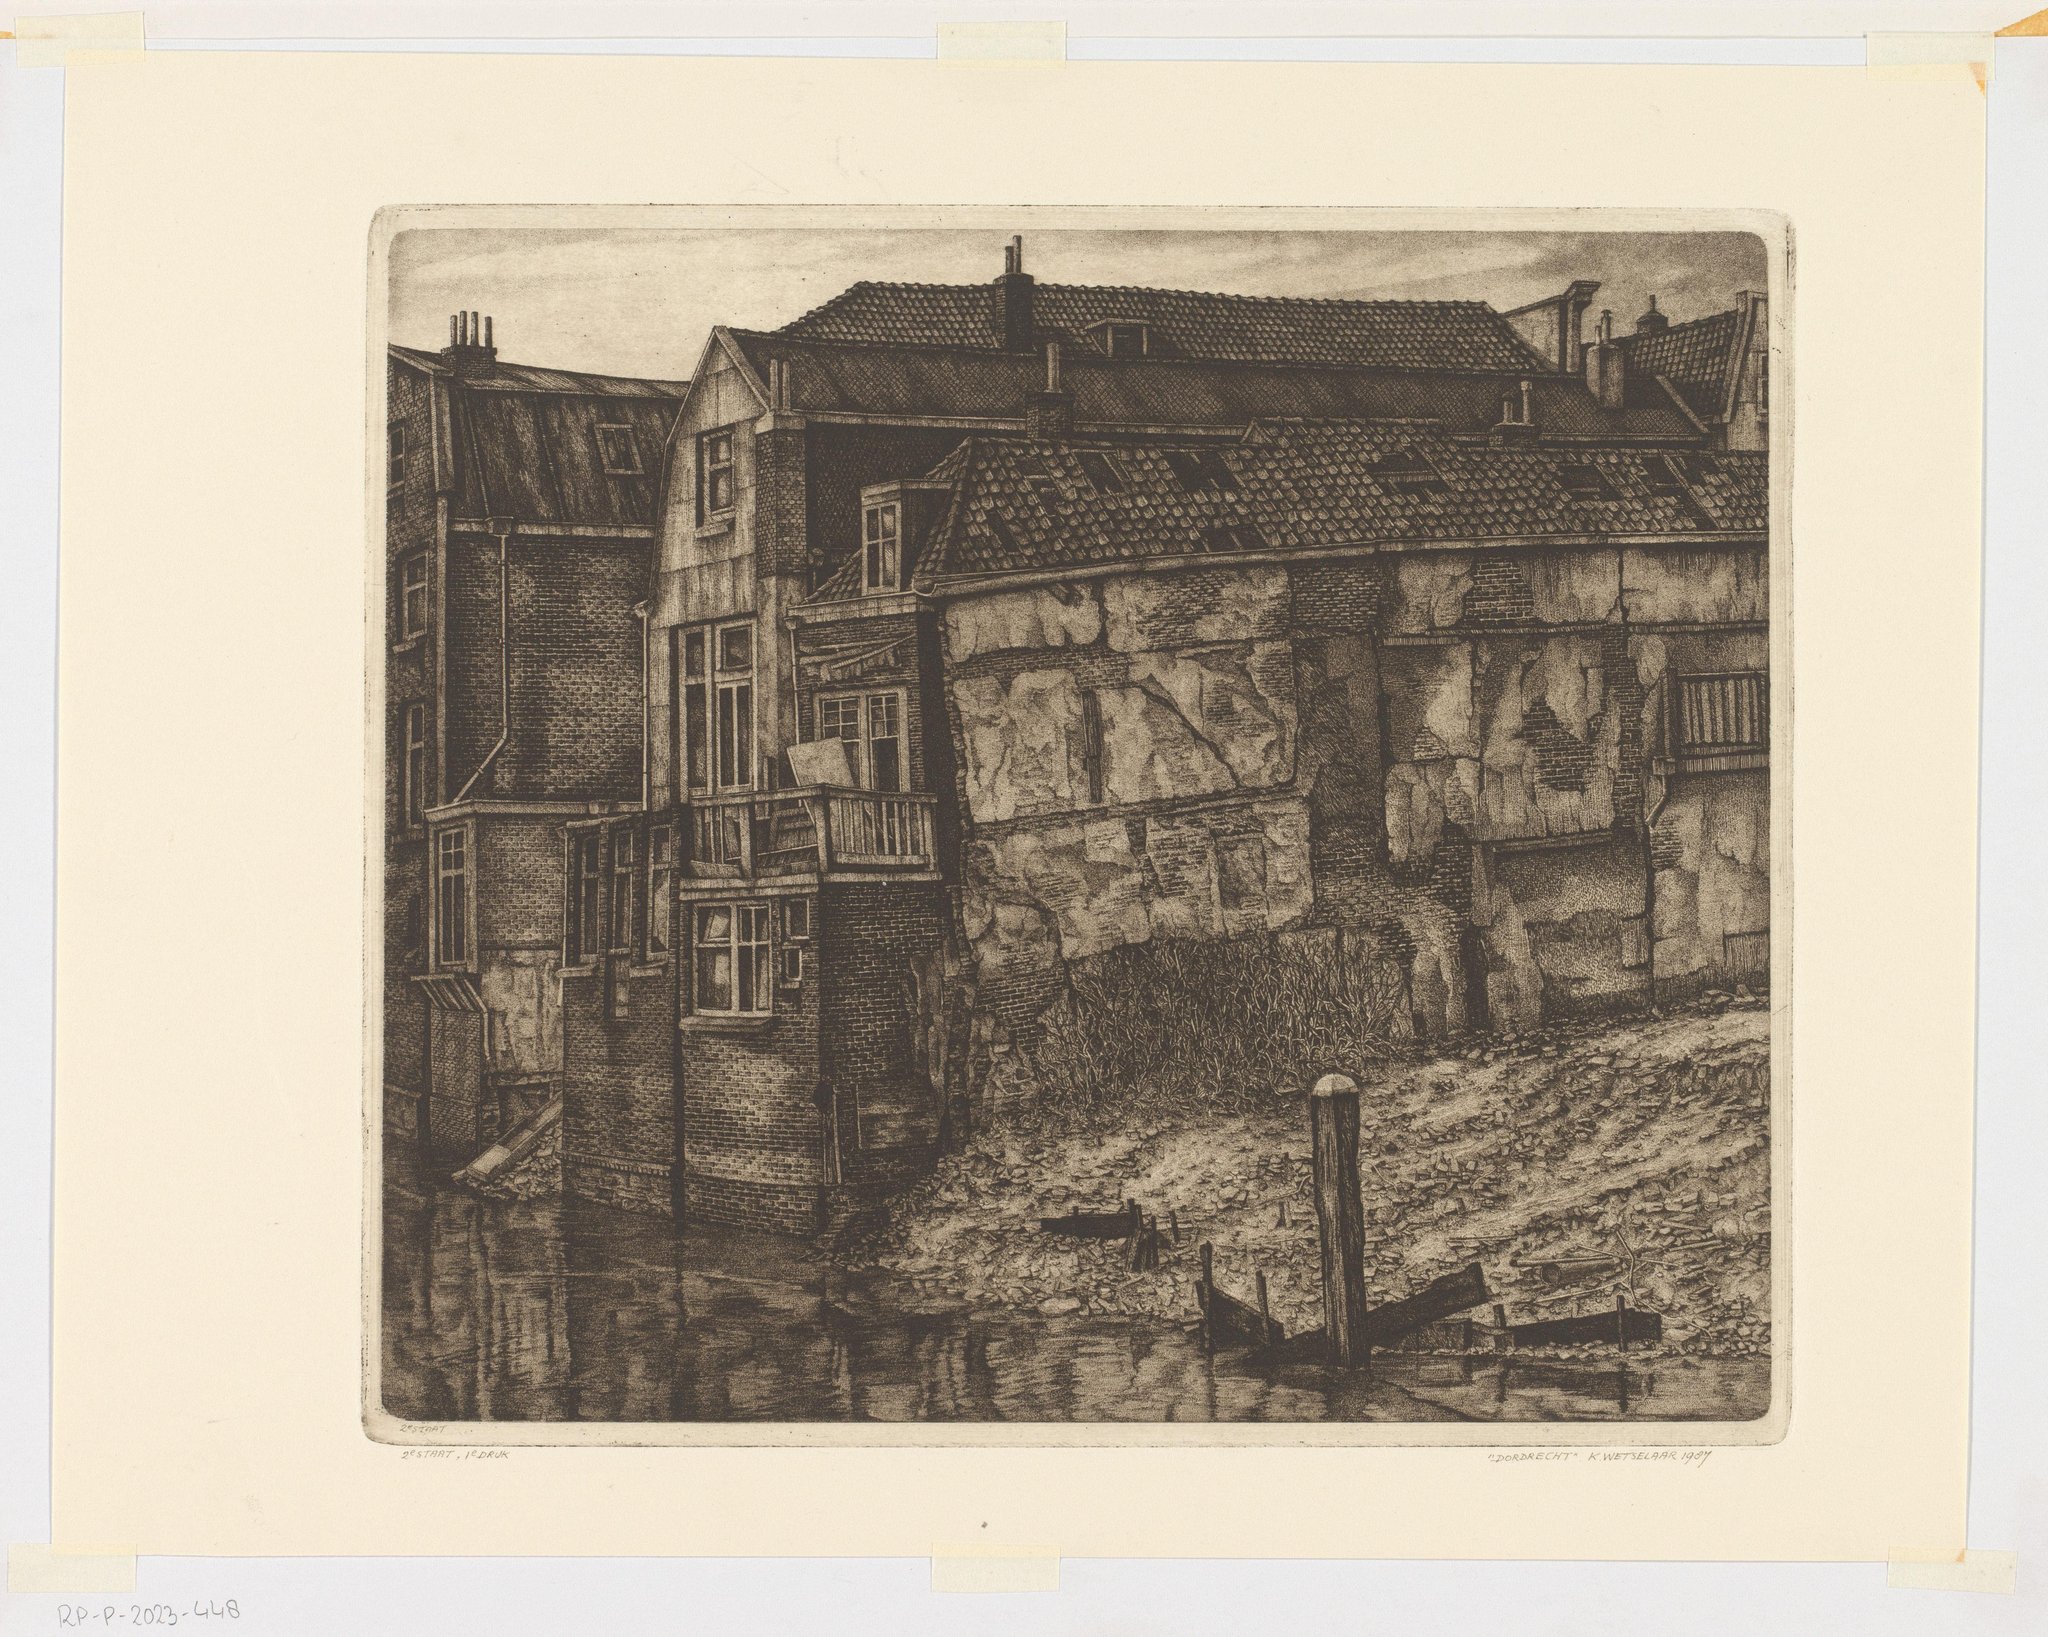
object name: print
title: Dordrecht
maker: karel wetselaar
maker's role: print maker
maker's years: 1935-2017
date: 1987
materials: paper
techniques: etching, retroussage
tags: façade (of house or building), dordrecht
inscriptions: inscription: ‘2e staat / 2e staat, 1e druk’, signature and date: ‘K. Wetselaar 1987’